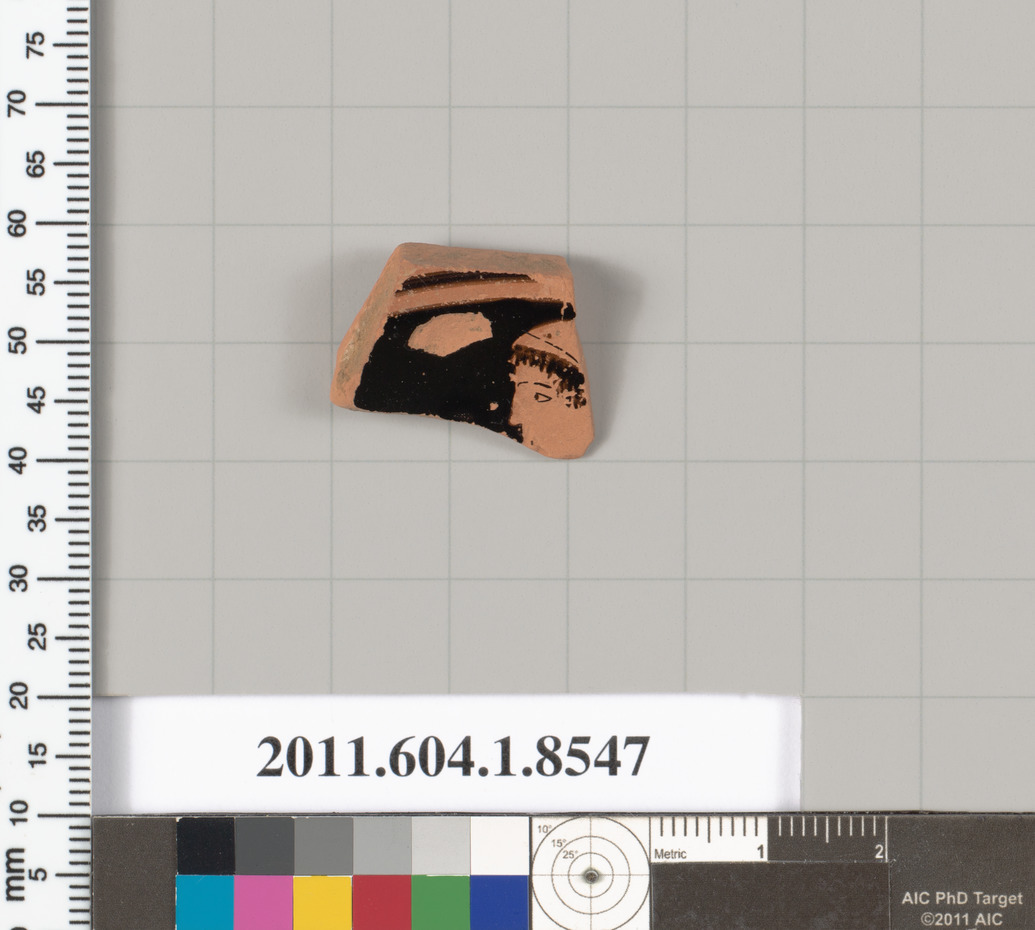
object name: kylix fragment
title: Terracotta fragment of a stemless kylix (drinking cup)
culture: greek, attic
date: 460-450 BCE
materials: terracotta